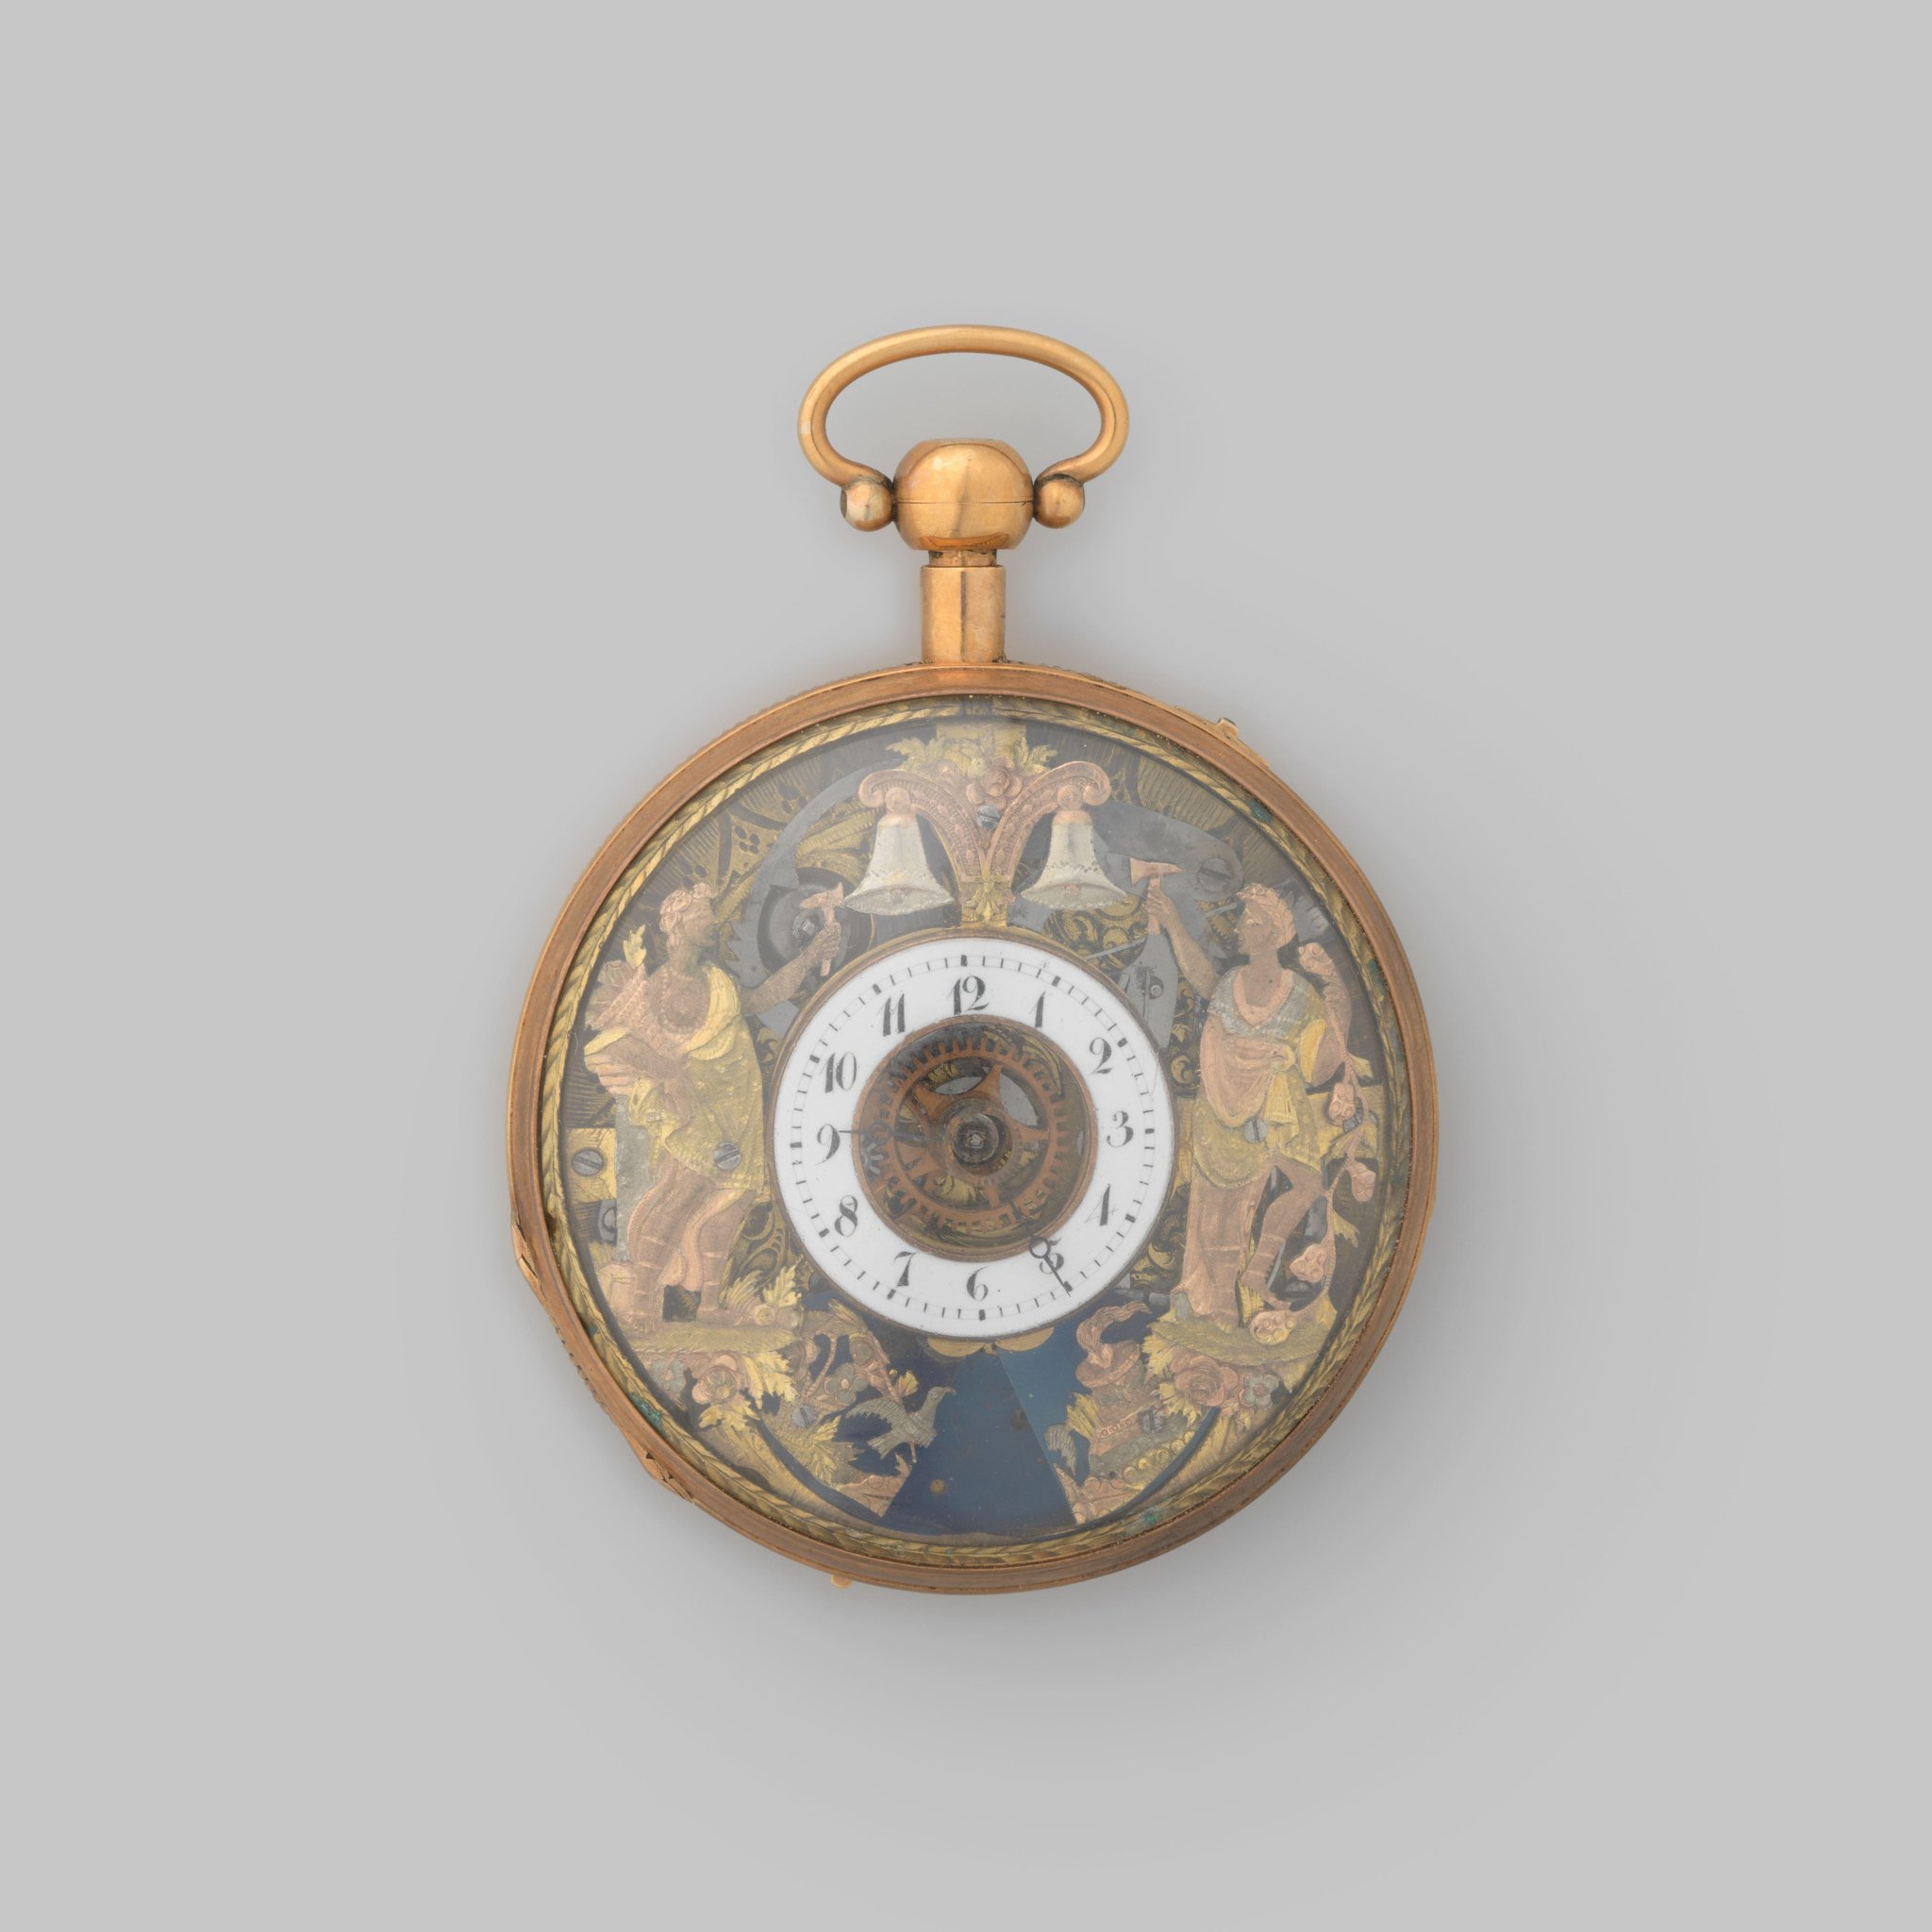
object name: wrist watch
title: Horloge van goud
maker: Anonymous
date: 1800-1900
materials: gold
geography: geneva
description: Gouden repetitie horloge. De wijzerplaat bestaat uit een kleine, wit geëmailleerde cijferring te midden van een à jour bewerkte voorstelling van een man en een vrouw die op twee klokken slaan. De achterbodem is geguillocheerd.